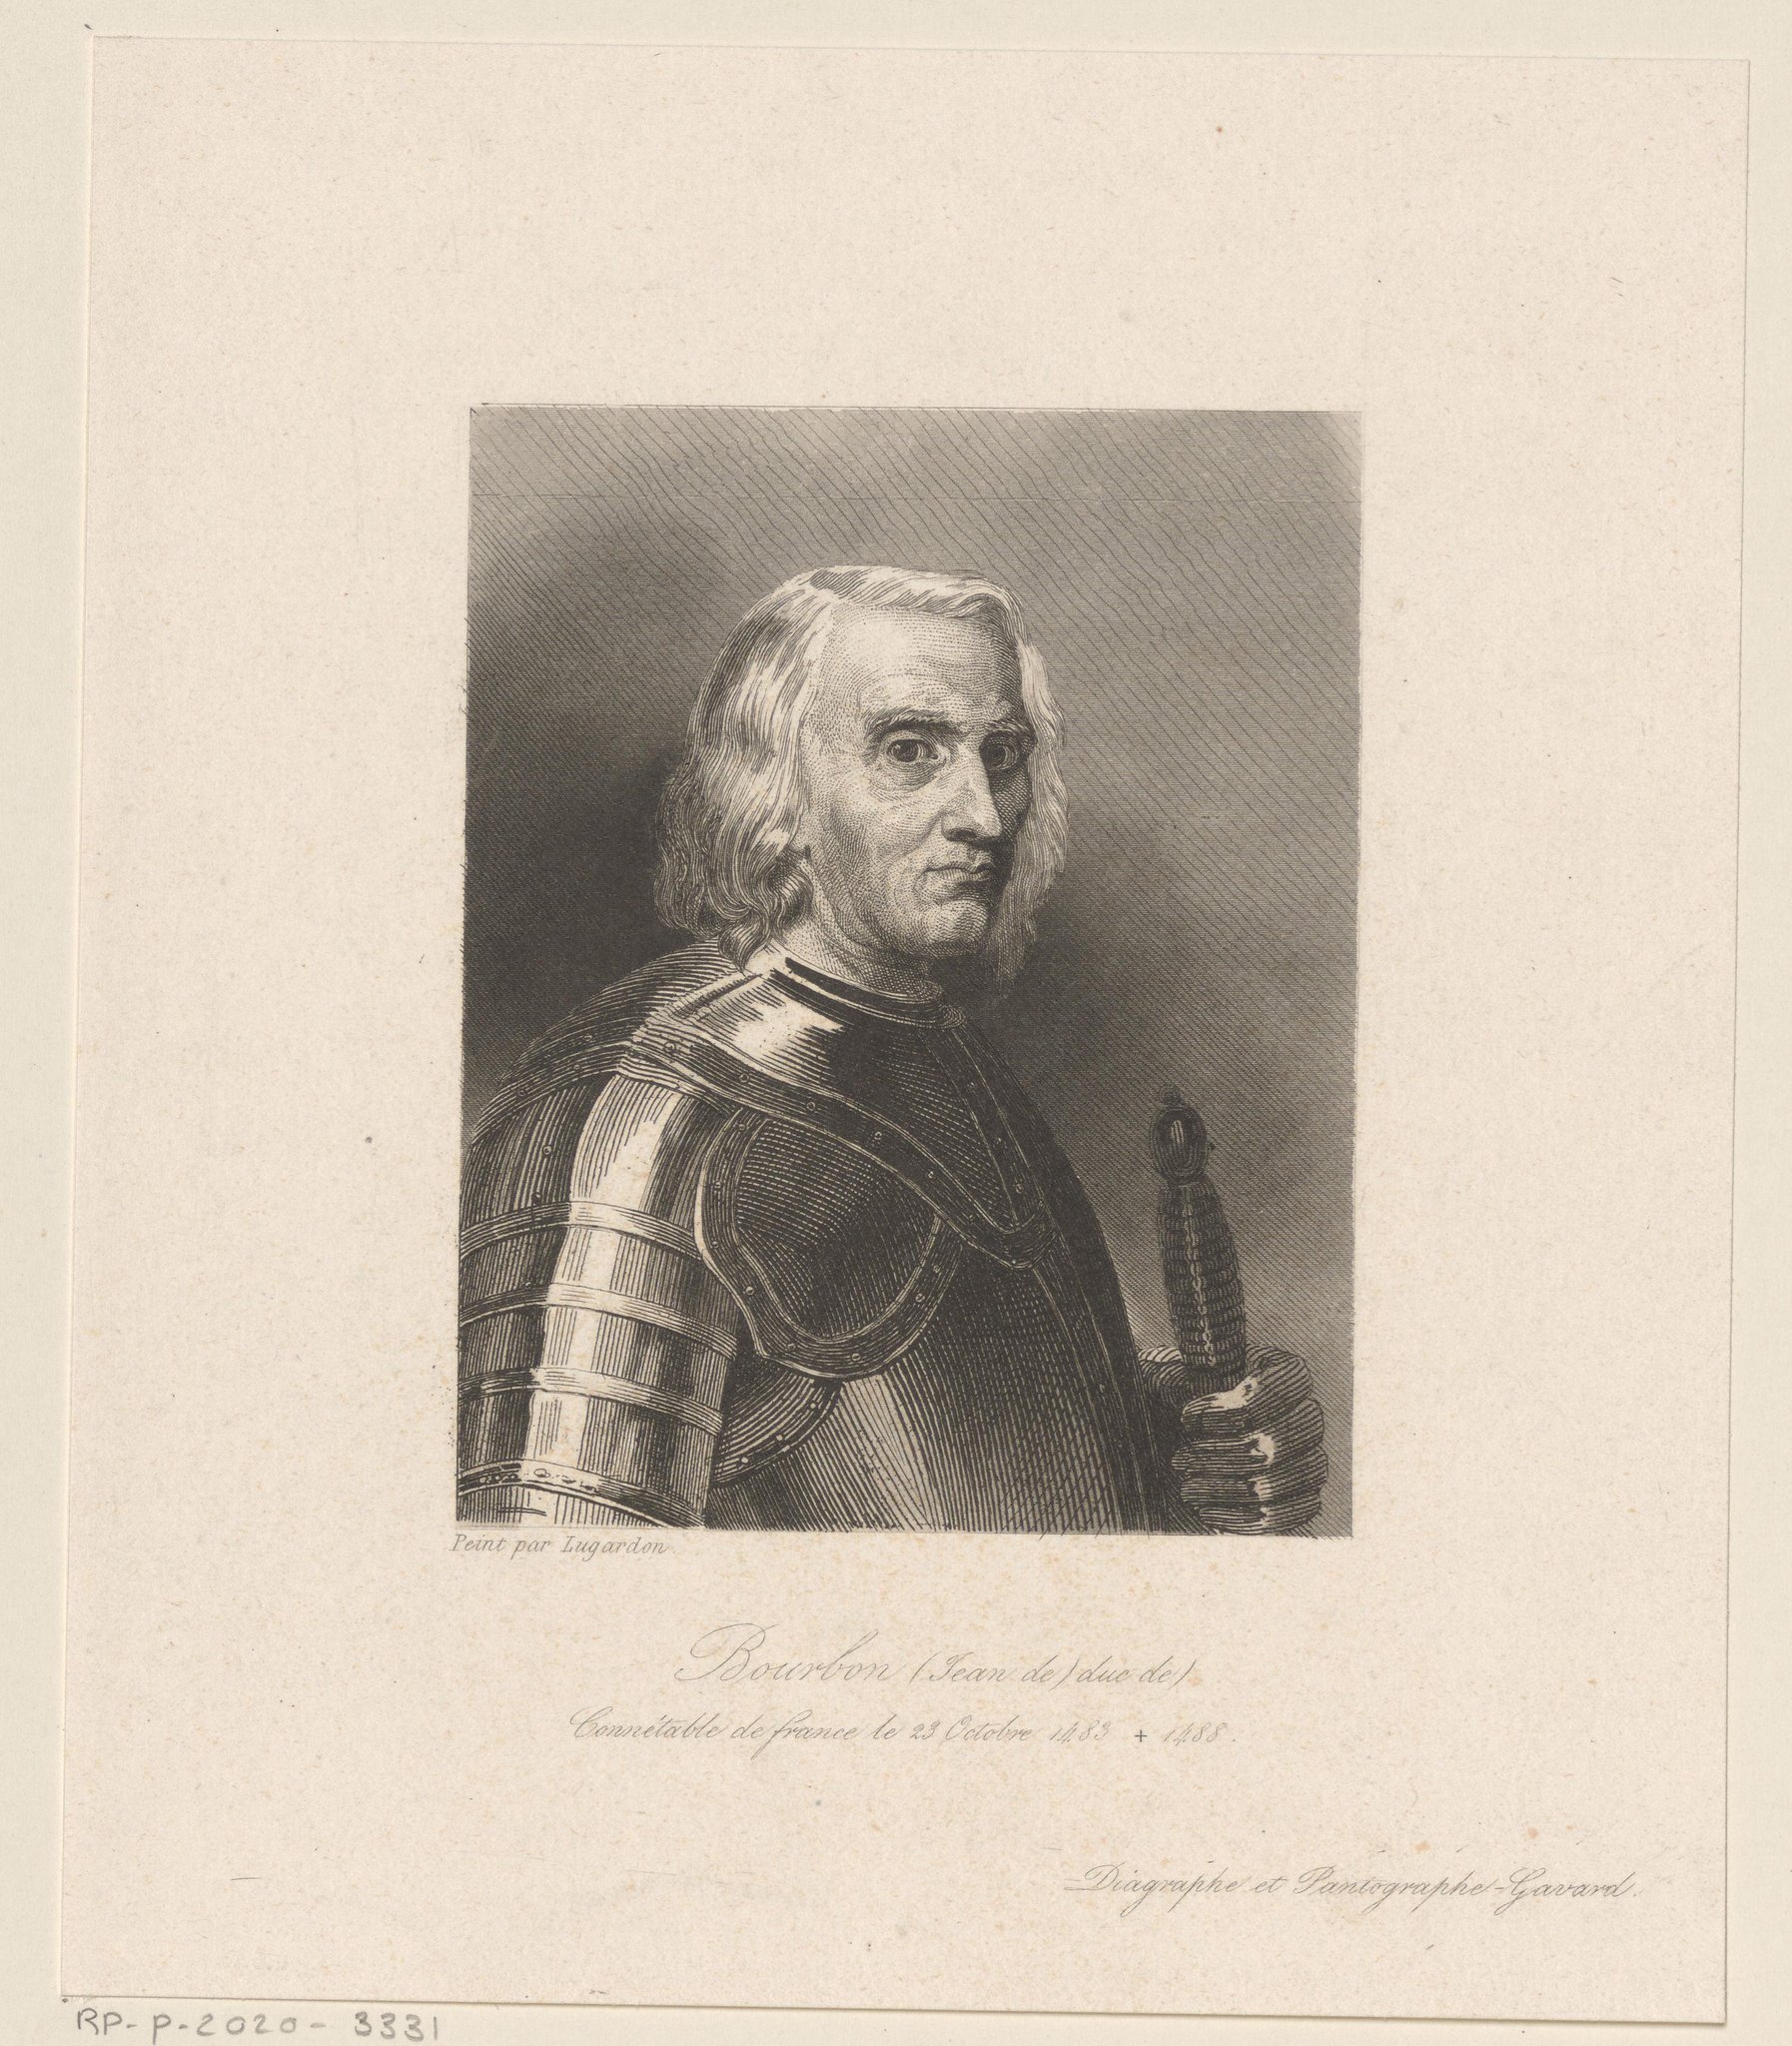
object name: print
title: Portret van Jan II, hertog van Bourbon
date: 1838-1842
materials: paper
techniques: engraving, etching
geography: paris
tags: armour, historical persons